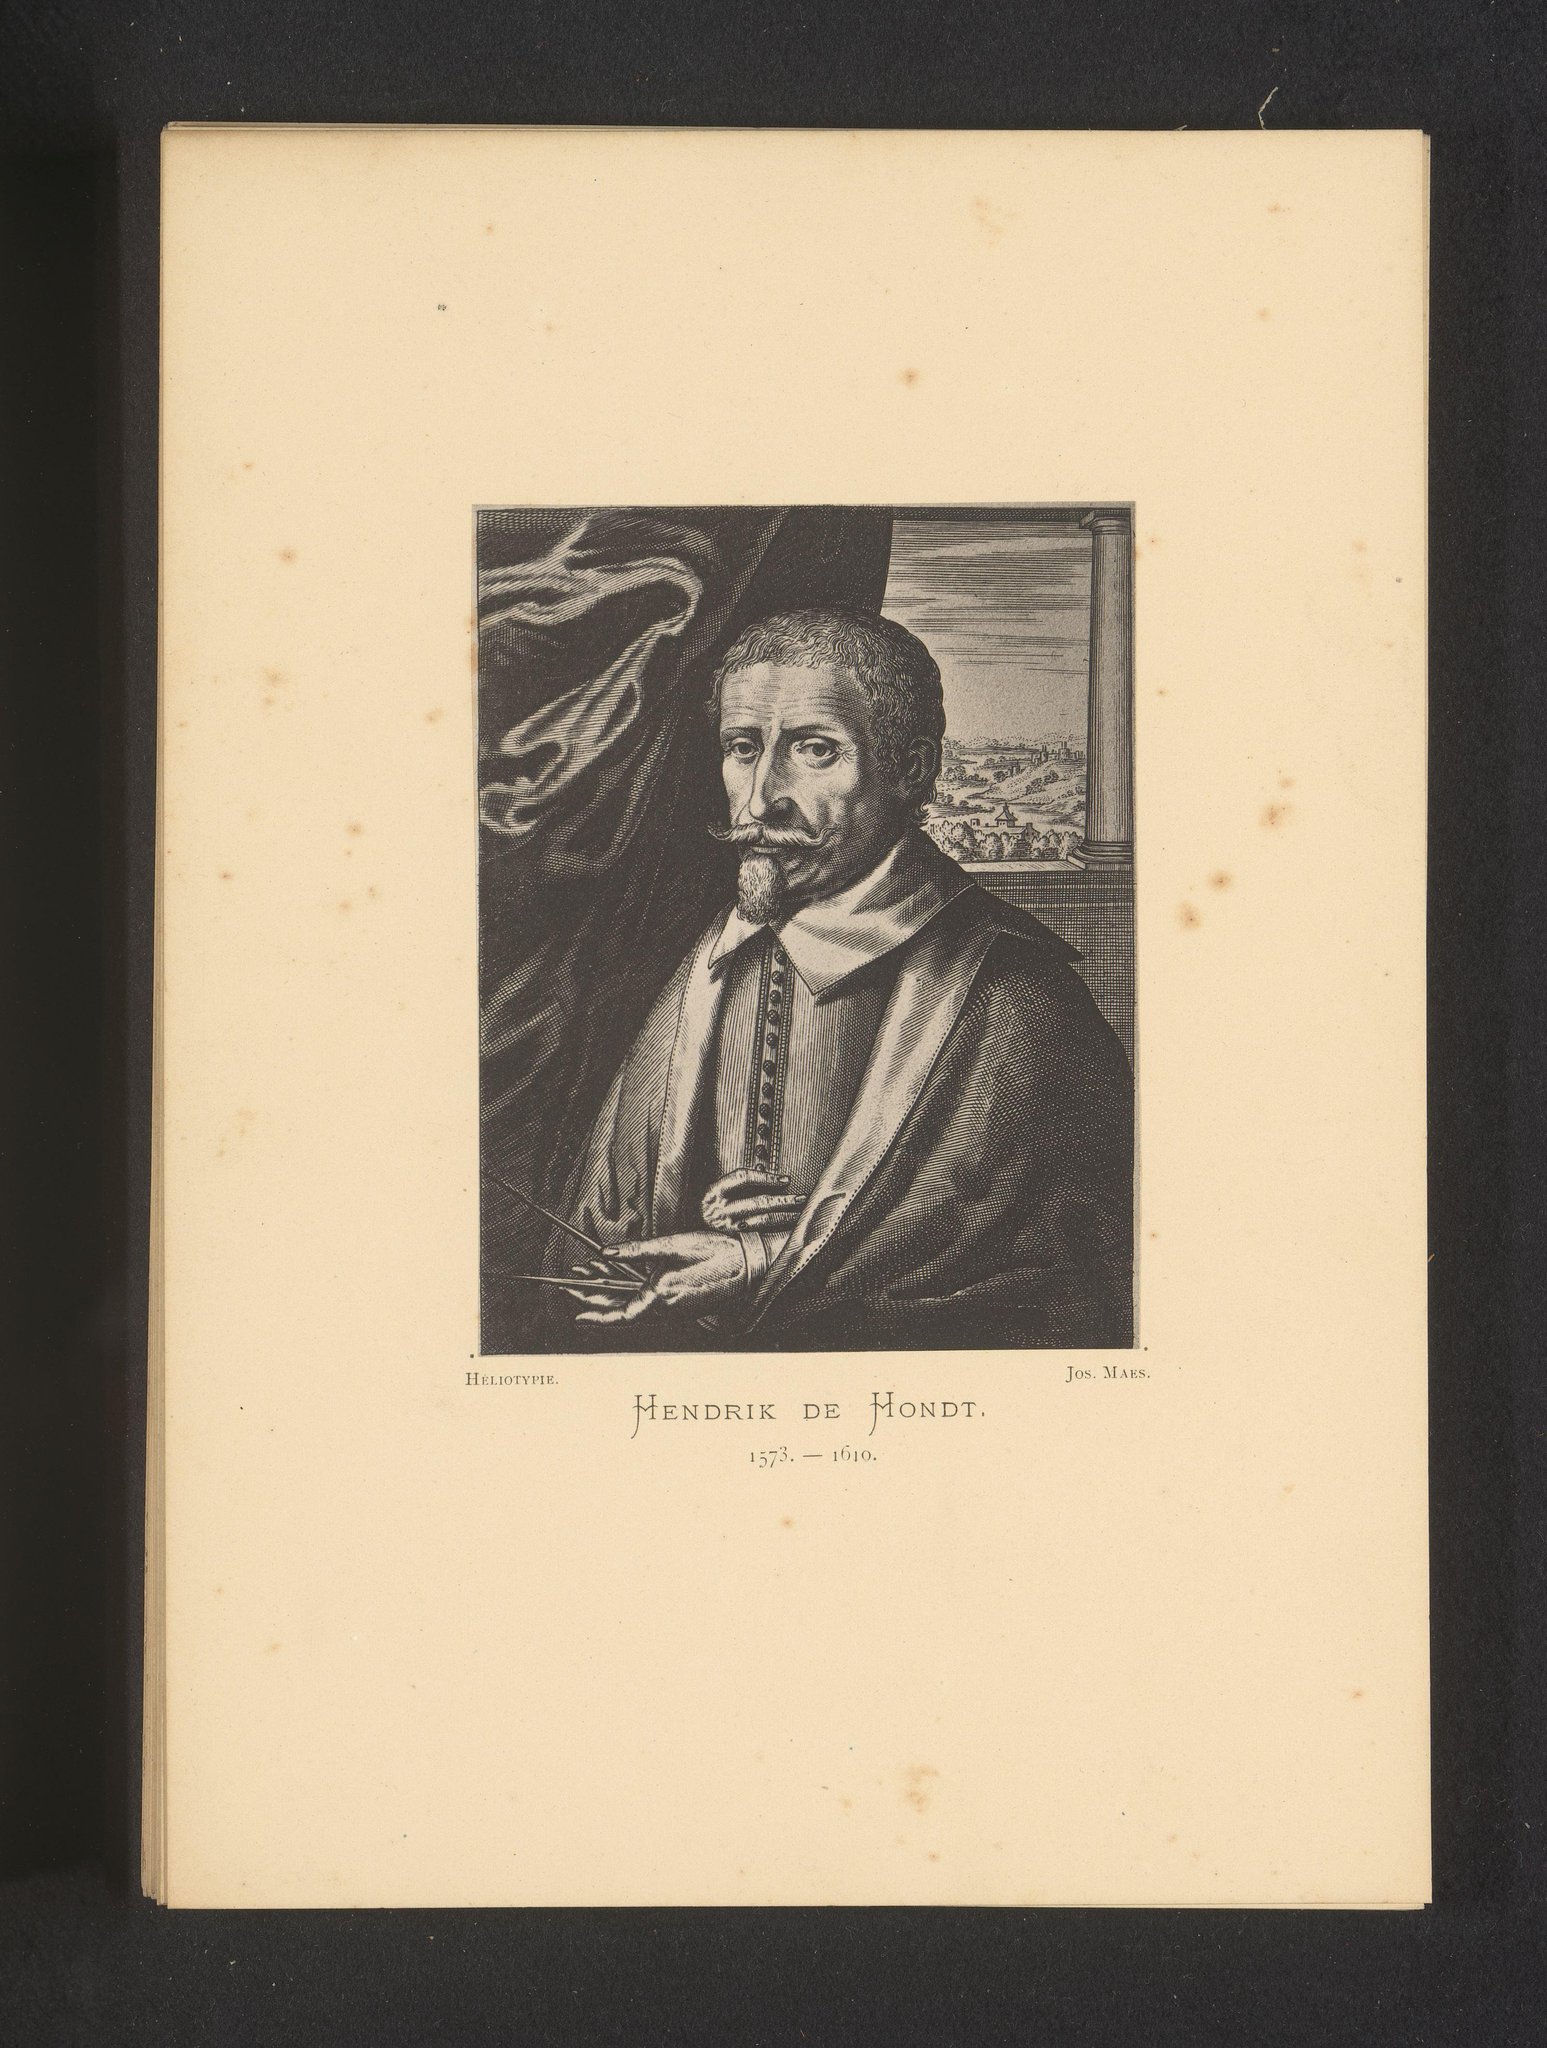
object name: photomechanical print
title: Reproductie van een gravure van een portret van Hendrick Hondius (I) door Frederik Bouttats (de Oude)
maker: joseph maes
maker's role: fotograaf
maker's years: 1838-1908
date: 1872-1877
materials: cardboard, paper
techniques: photograph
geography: antwerp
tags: print maker, draughtsman, hendrick hondius (i), historical persons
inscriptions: inscription: ‘1573. - 1610.’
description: Deze prent maakt deel uit van een omslag met 150 prenten en een katern met een lijst van afbeeldingen.